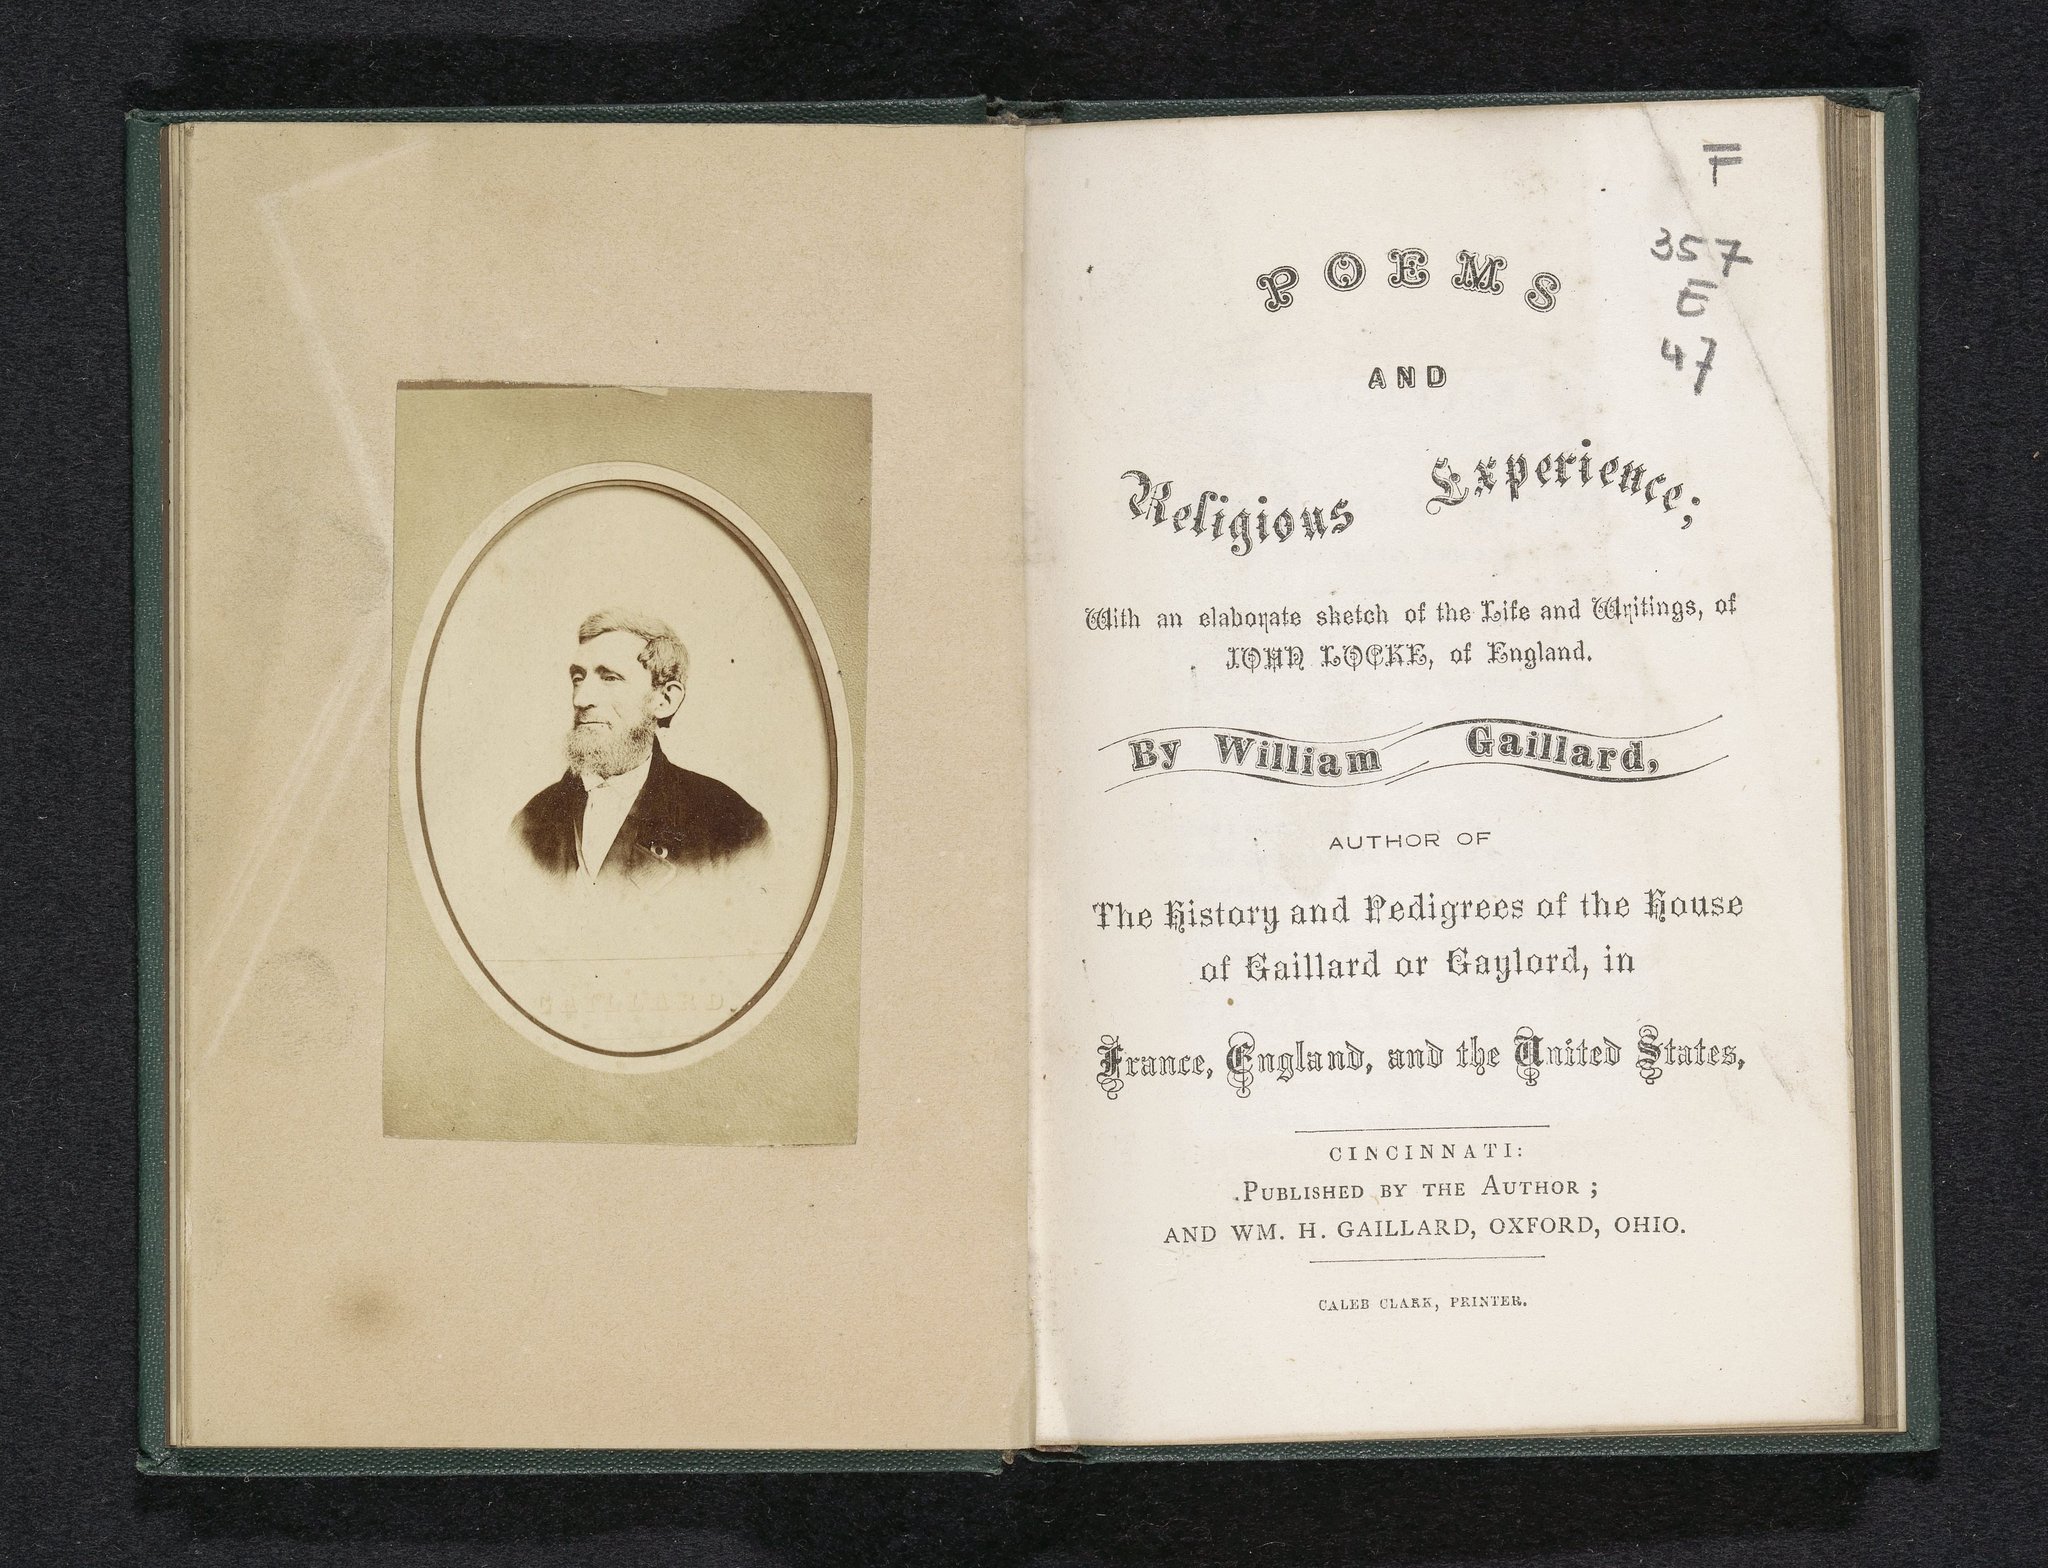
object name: book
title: Poems and religious experience : with an elaborated sketch of the life and writings of John Locke, of England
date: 1875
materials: cardboard, linen, paper, photographic support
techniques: albumen print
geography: cincinnati